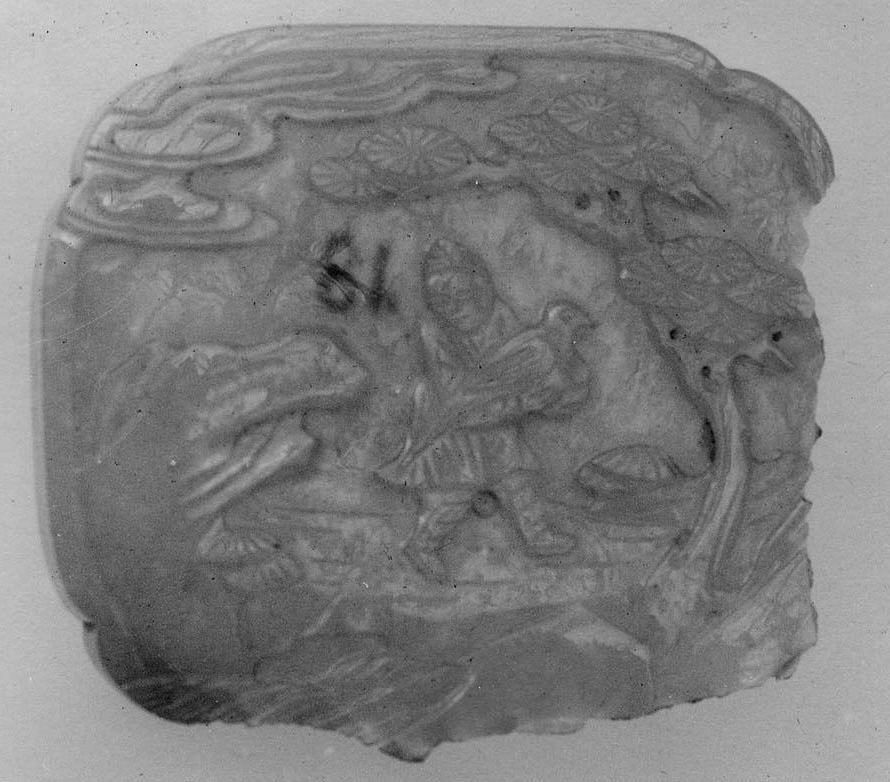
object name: fragment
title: Fragment of a Worked Object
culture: chinese or turkestani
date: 1902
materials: jade